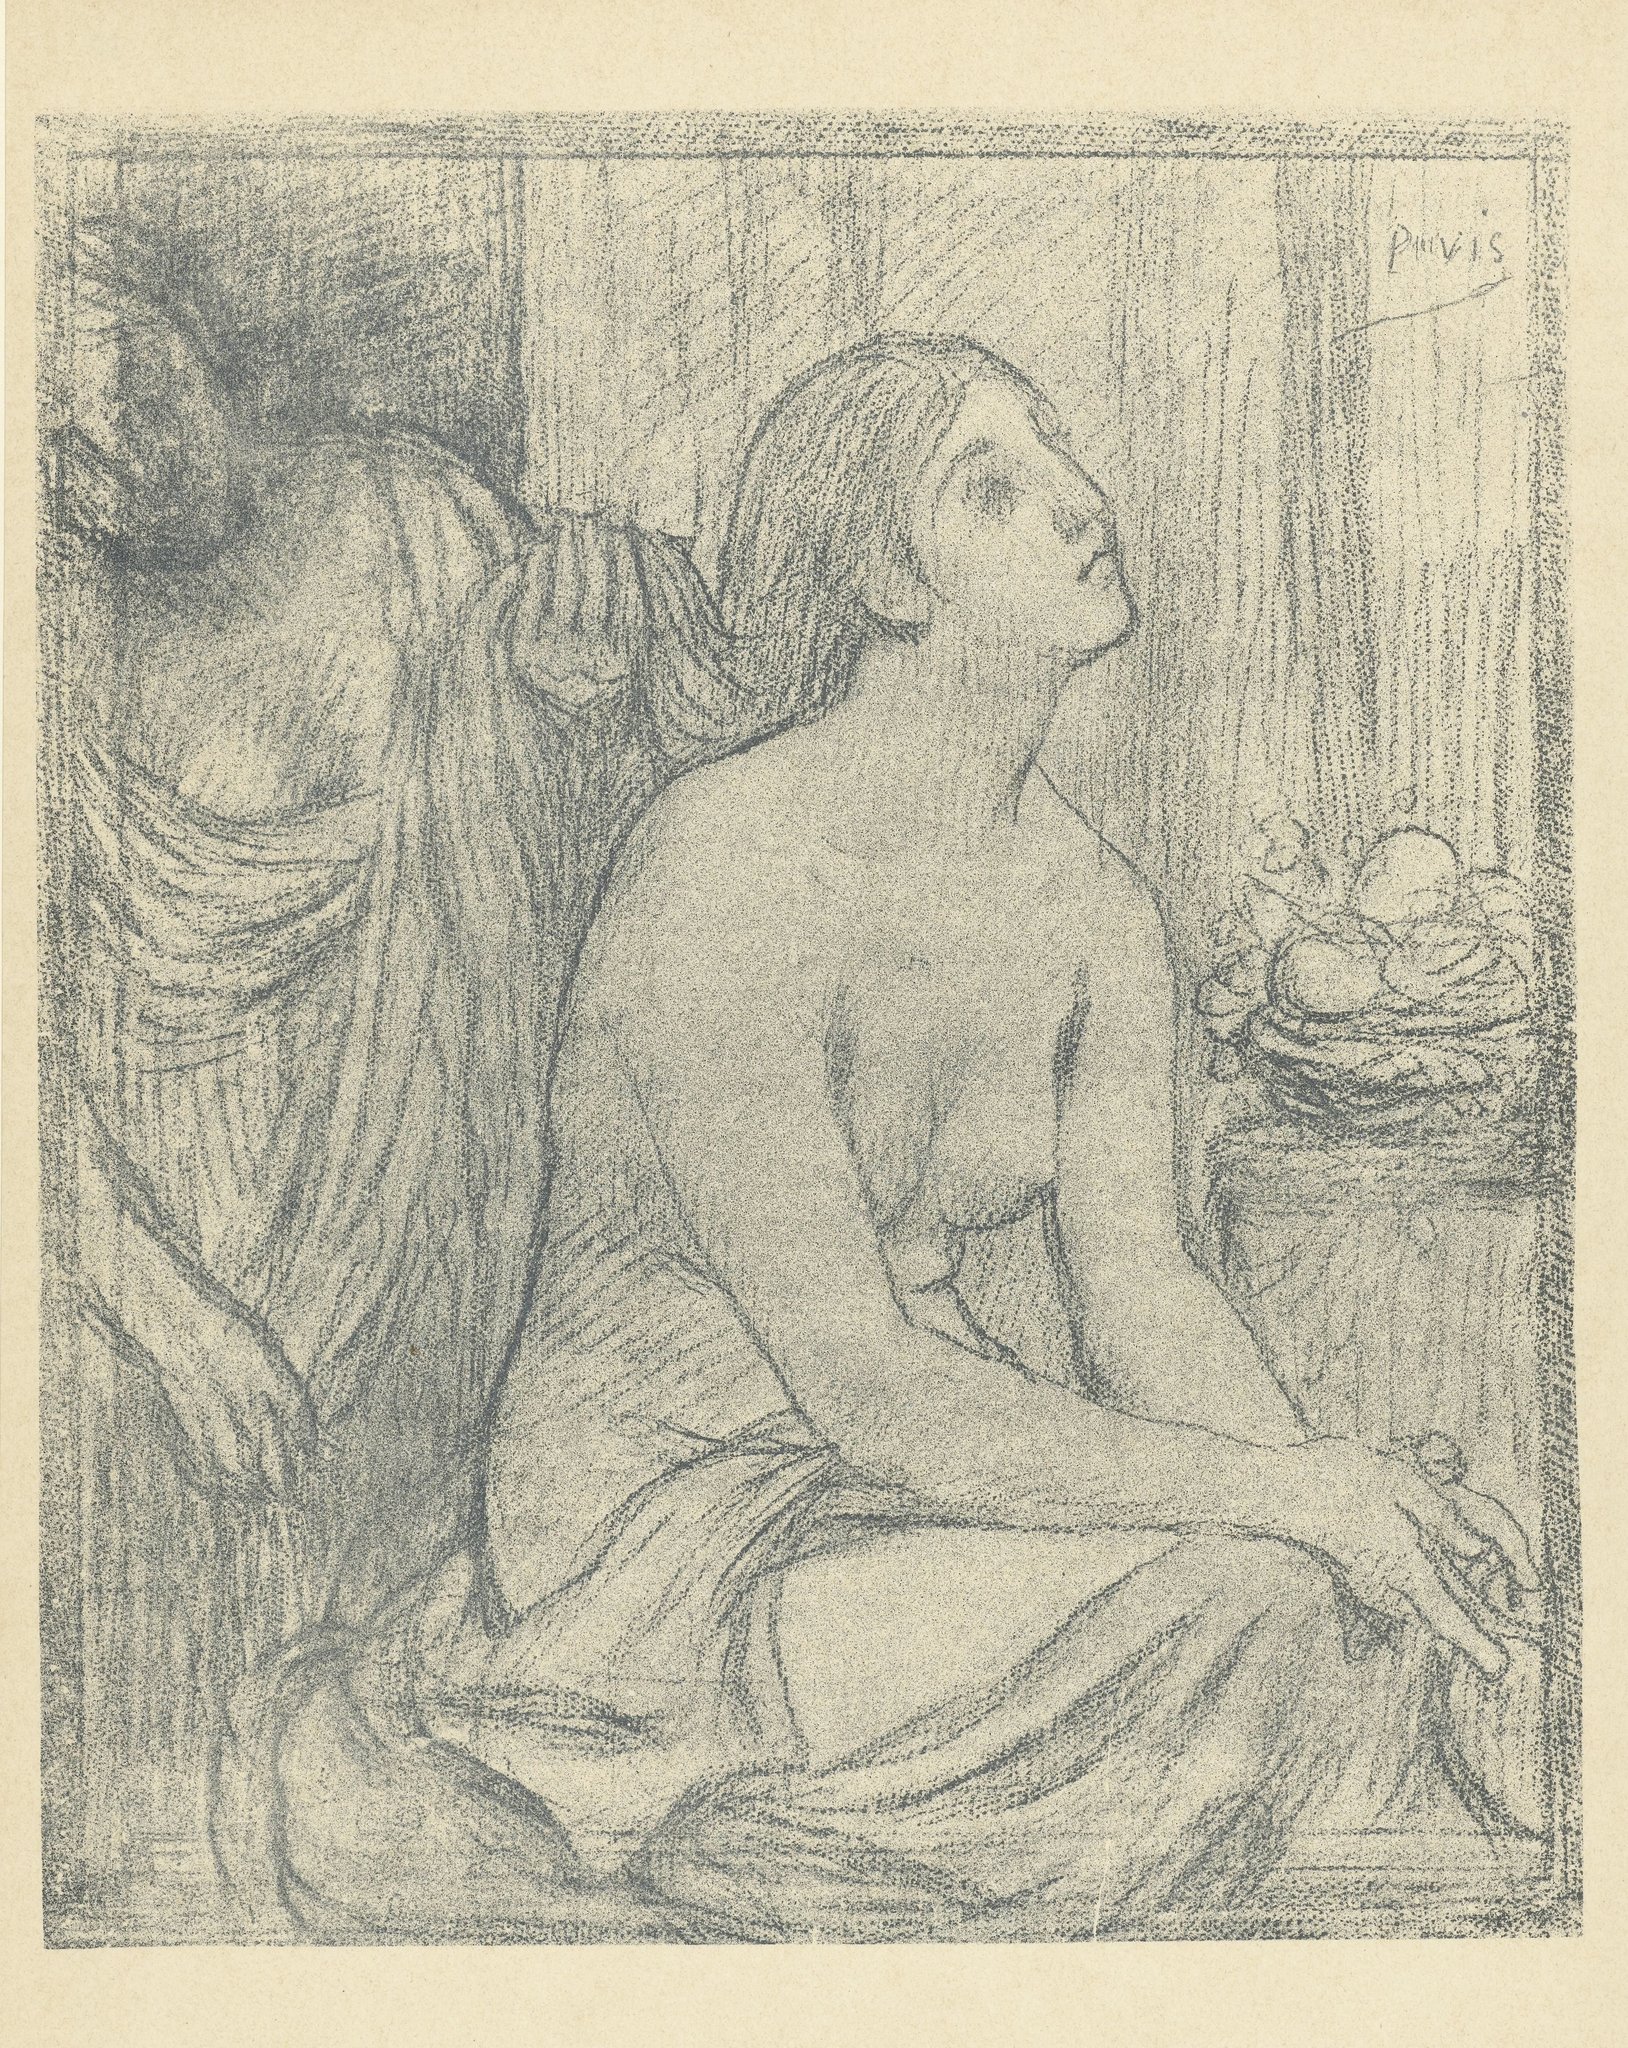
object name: print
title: L'Epreuve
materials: paper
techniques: photography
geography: paris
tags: making toilet, the (nude) human figure; 'corpo humano' (ripa), female sex; woman, servant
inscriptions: collector's mark: Lugt 2760, collector's mark: Lugt 2228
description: Verschenen in album met tien originele prenten als supplement bij tijdschrift: L'Epreuve, maart 1895, prent nr. 1